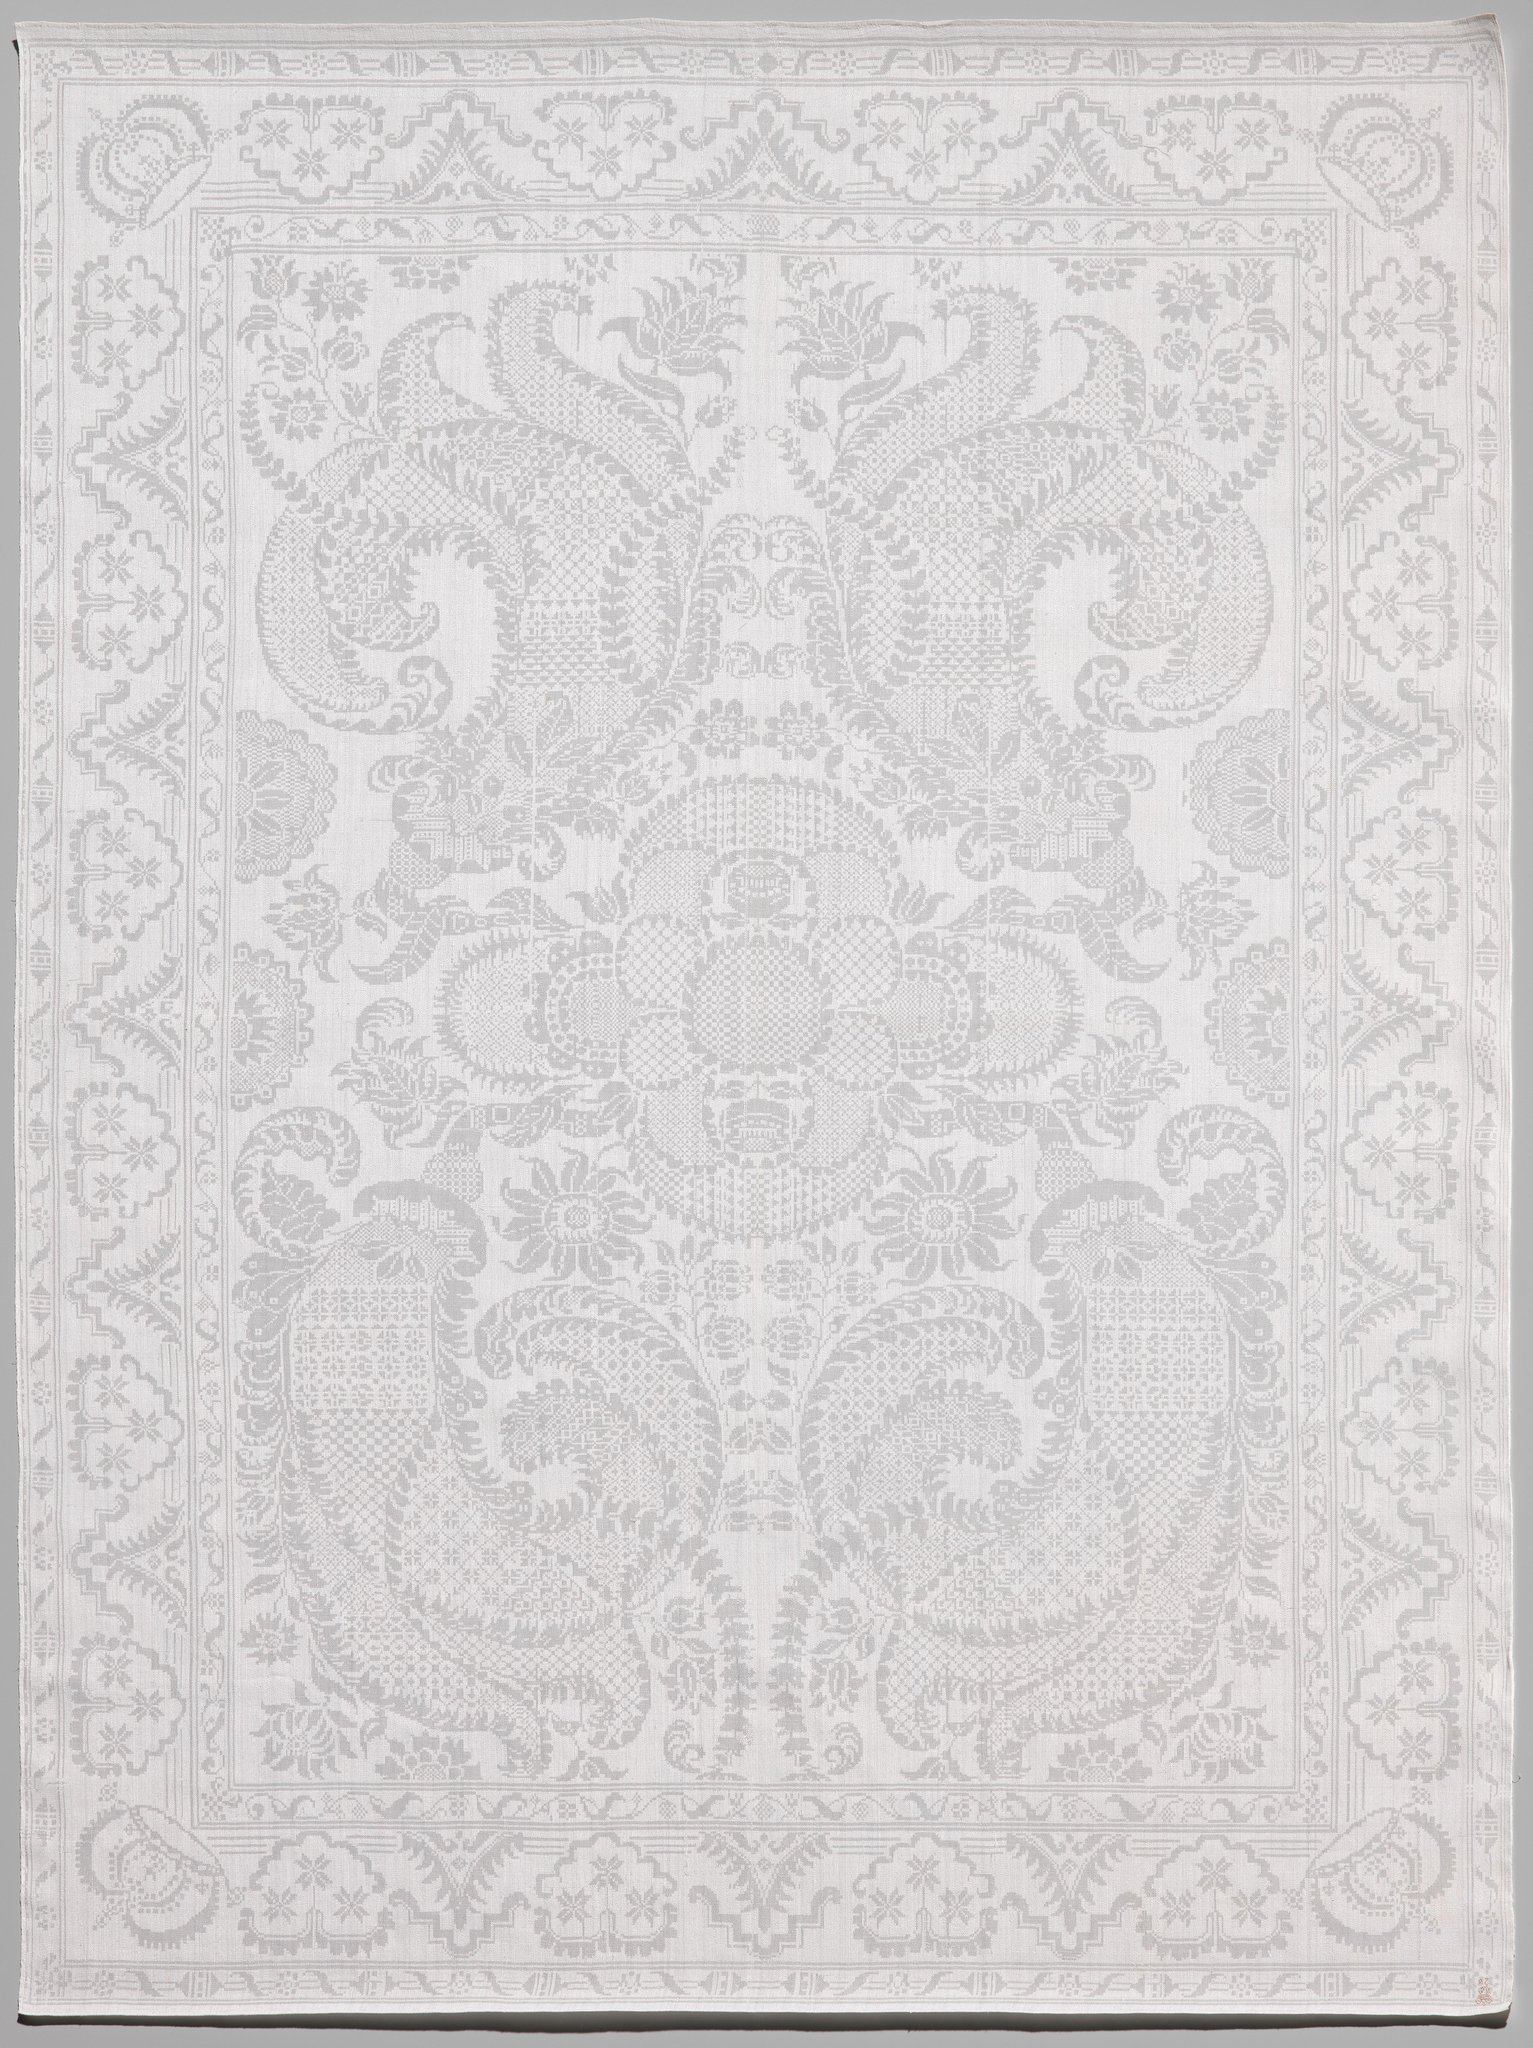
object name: napkin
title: Servet van linnendamast met een kantpatroon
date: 1723-1730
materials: linen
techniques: damask, weave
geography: northern netherlands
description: Wit linnendamasten servet met patroon van voluten, merk: kroon WG 26.